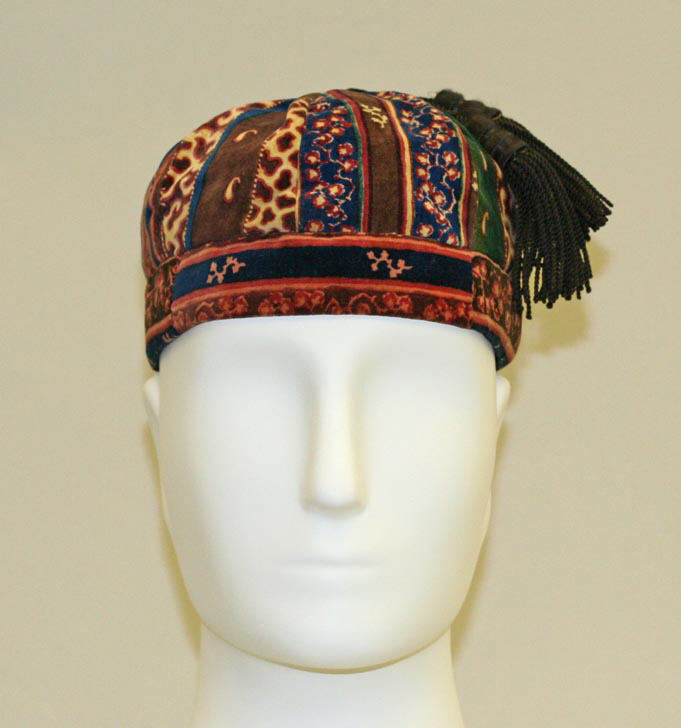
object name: cap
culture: european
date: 1801-1833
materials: cotton, silk